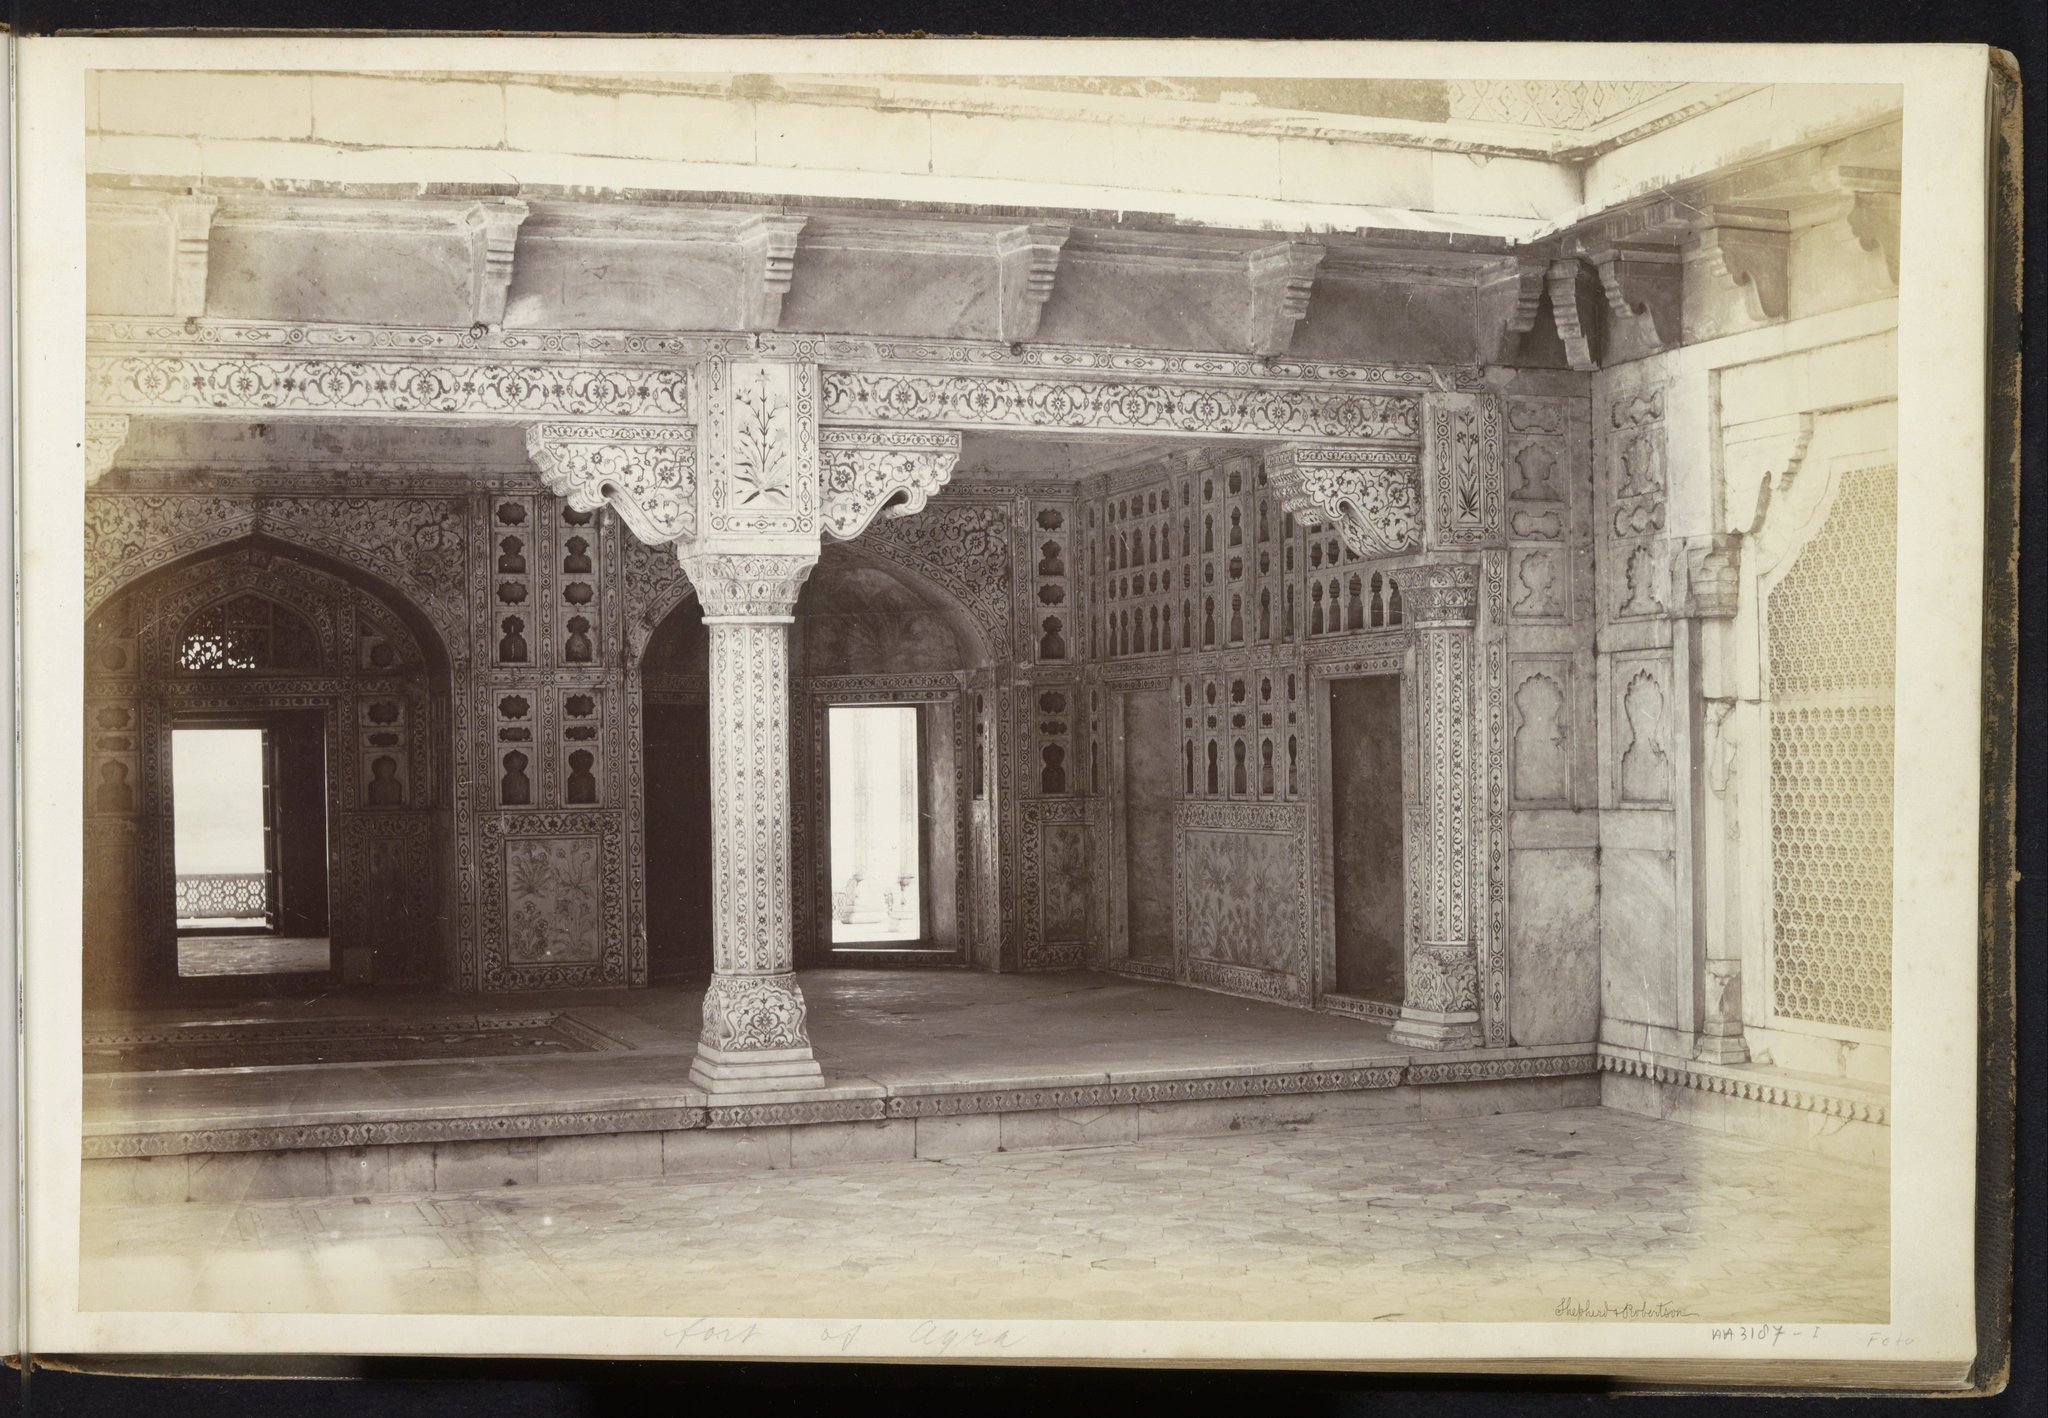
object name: album leaf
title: Interior of the Agra Fort, Uttar Pradesh, India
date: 1862-1863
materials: photographic support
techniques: albumen print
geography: agra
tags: fortress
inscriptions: title: ‘Fort of Agra’, name: ‘Shepherd & Robertson’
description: Onderdeel van Reisalbum met opnames van bezienswaardigheden in India, Duitsland, Zwitserland en Frankrijk.